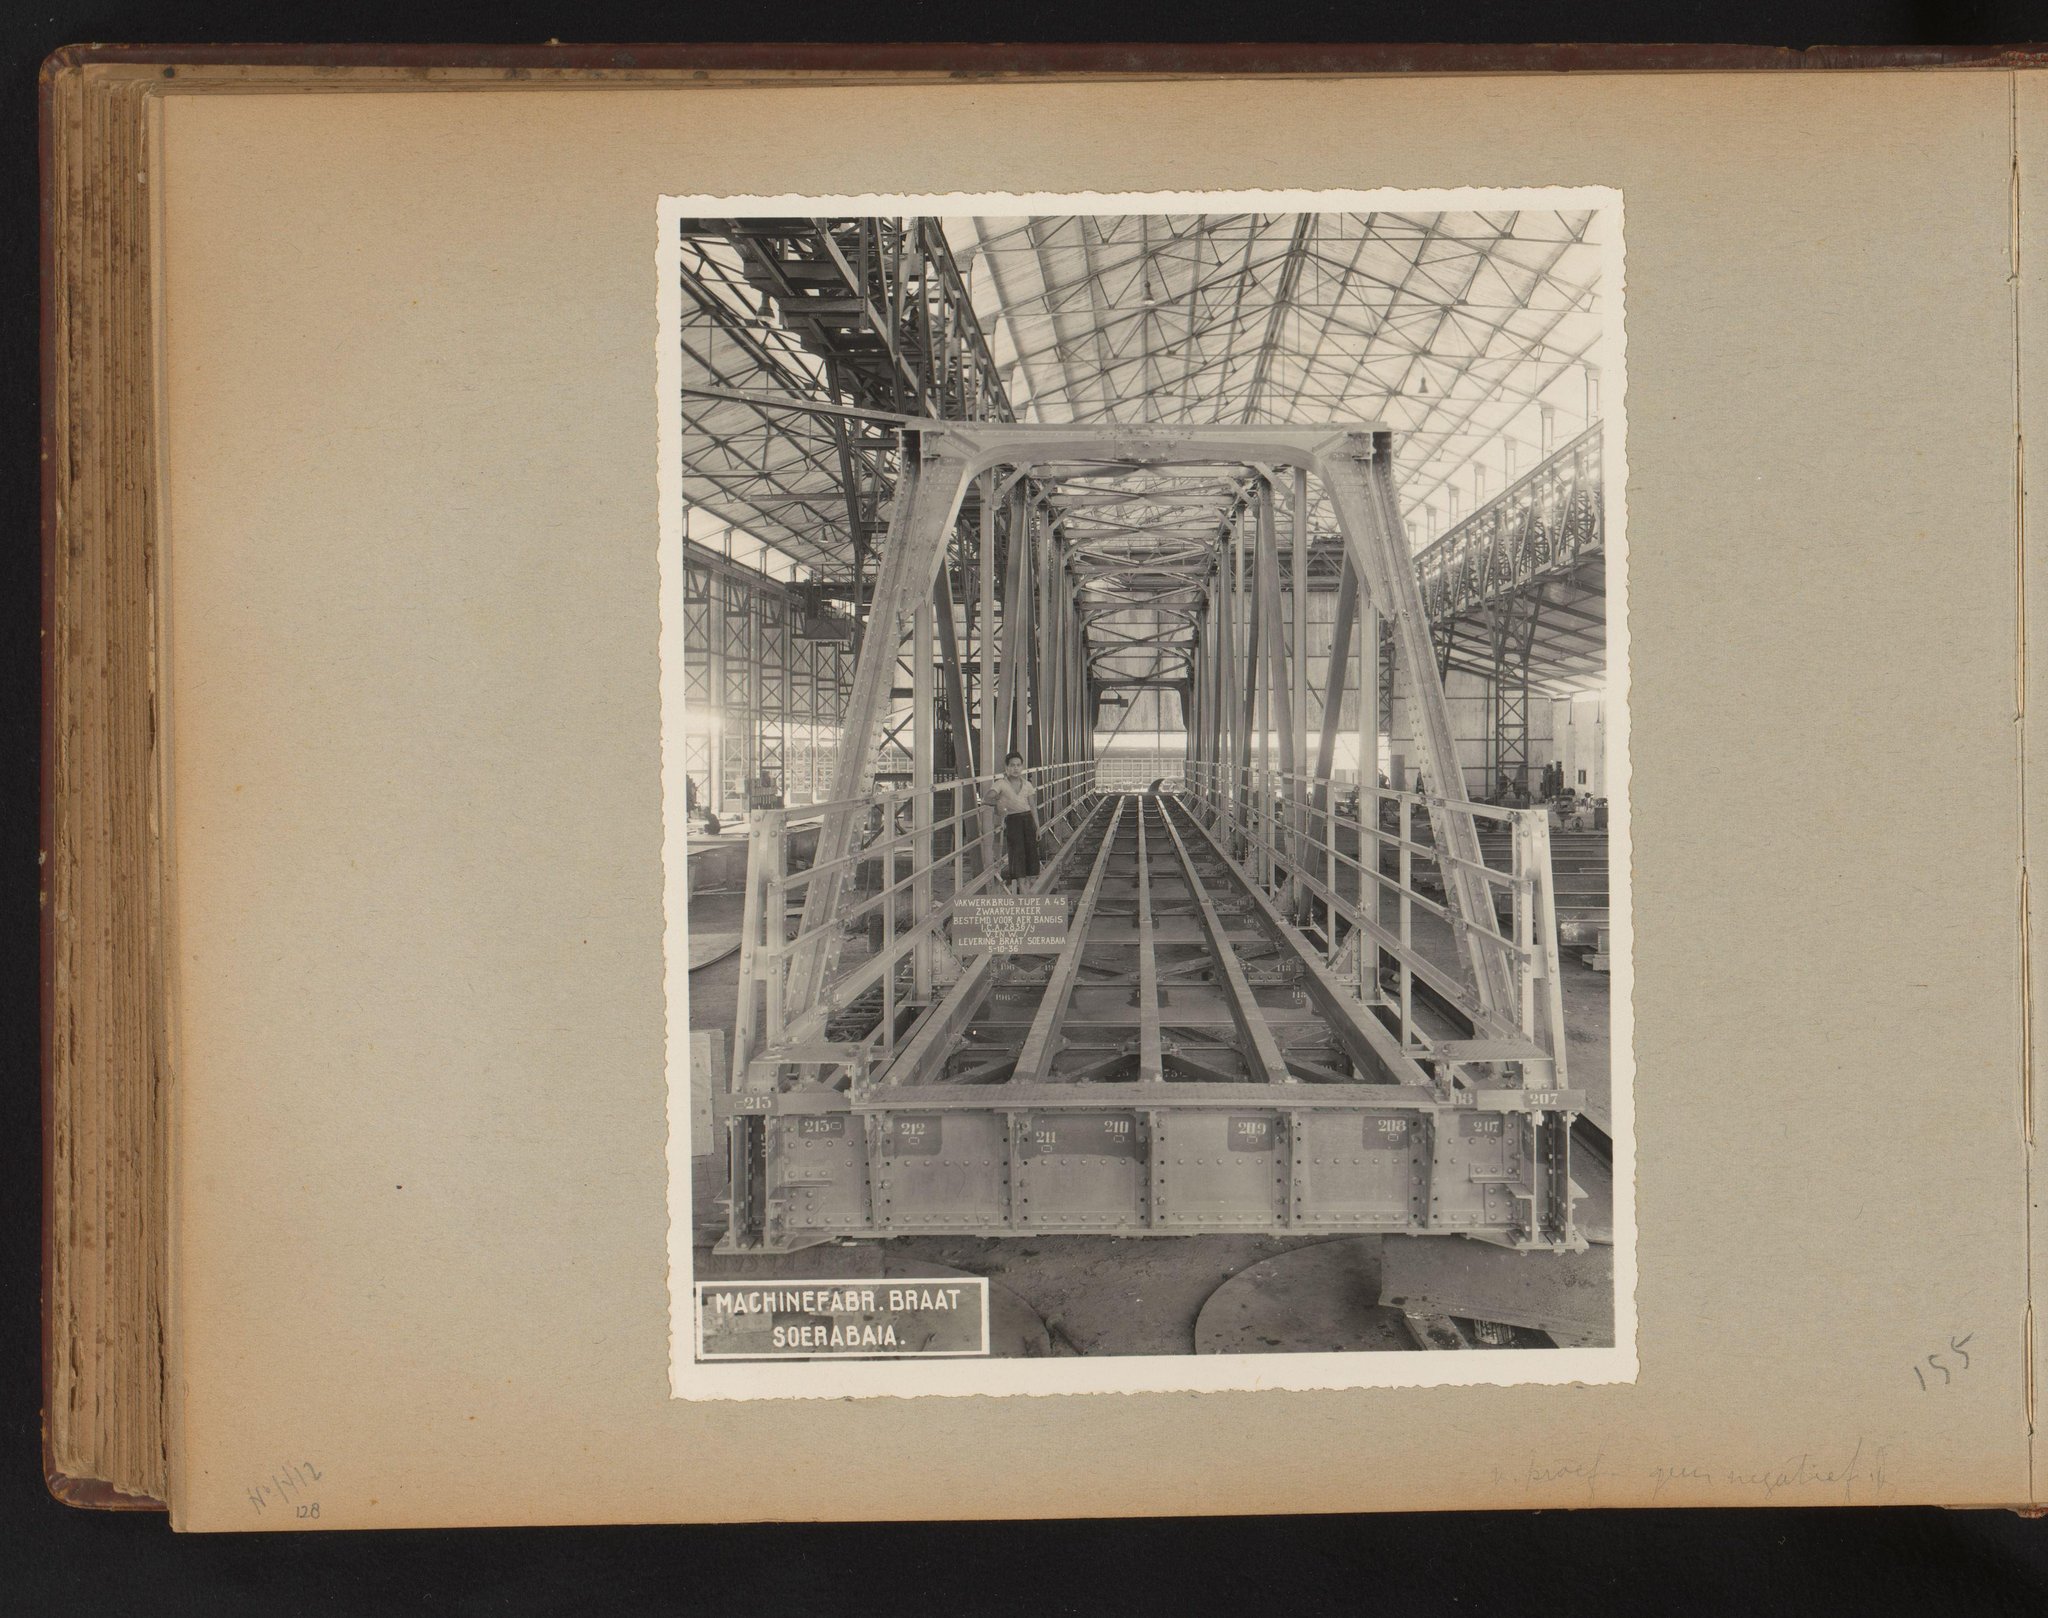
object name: album leaf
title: Spoorbrug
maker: Anonymous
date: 1936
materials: cardboard, photographic support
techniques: gelatin silver print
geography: surabaya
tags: factory-interior, machine shop, railway, train, java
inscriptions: date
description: Albumblad met een foto van een vakwerkbrug (spoorbrug) bestemd voor Aer (Ajer) Bangis, 5 oktober 1936. Onderdeel van een fotoalbum met foto's van machines en constructies van de N.V. Machinefabriek Braat te Soerabaja, Soekaboemi en Tegal uit de periode 1931-1937.